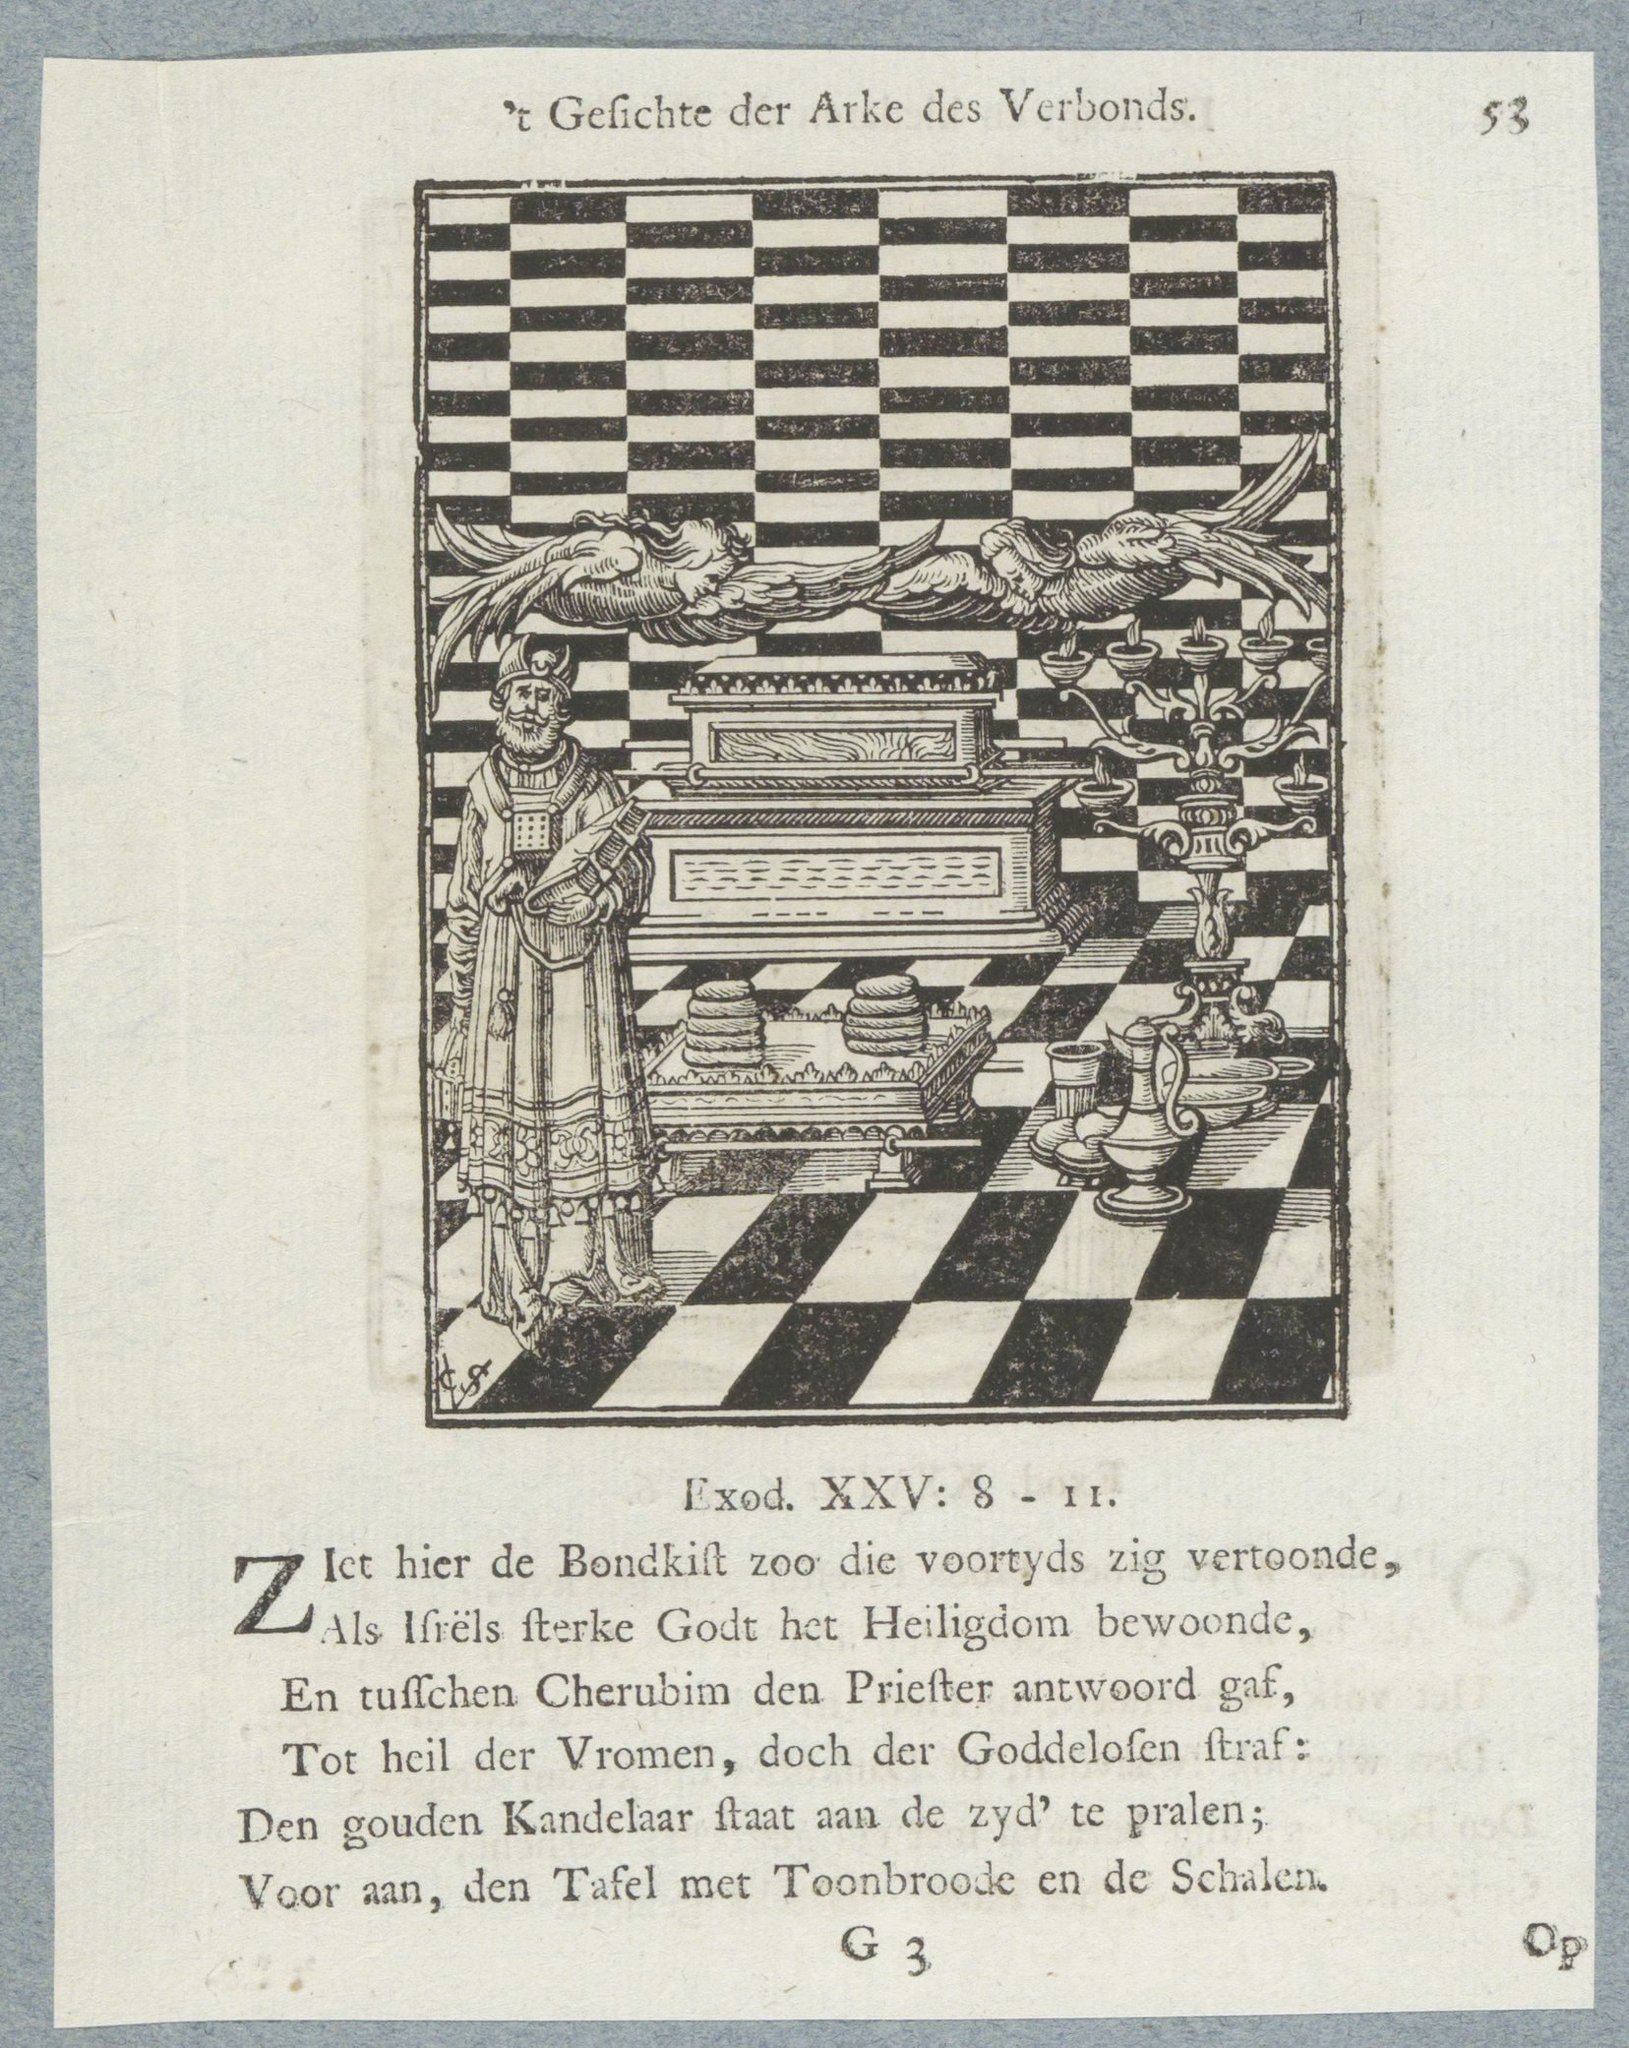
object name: print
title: 't Gesichte der arke des verbonds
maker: jan klooster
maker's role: bookseller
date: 1645-1646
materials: paper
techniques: letterpress printing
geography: amsterdam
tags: other objects kept in the tabernacle, ark of the covenant ~ jewish religion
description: De voorstelling is gebaseerd op een prent van Hans (II) Holbein, daar zonder Aäron in priestergewaad. De prent is afkomstig uit: Bybels Lusthof. Amsterdam, J. Klooster, 1740. De prent werd gemaakt voor de uitgaven van P.J. Paets uit Amsterdam. Ze komt in ieder geval voor in: Bibels Tresoor ofte der zielen lusthof. Amsterdam, P.J. Paets, 1646. Mogelijk staat ze ook in: Historien ende Prophetien. [Amsterdam], P.J. Paets, 1645.